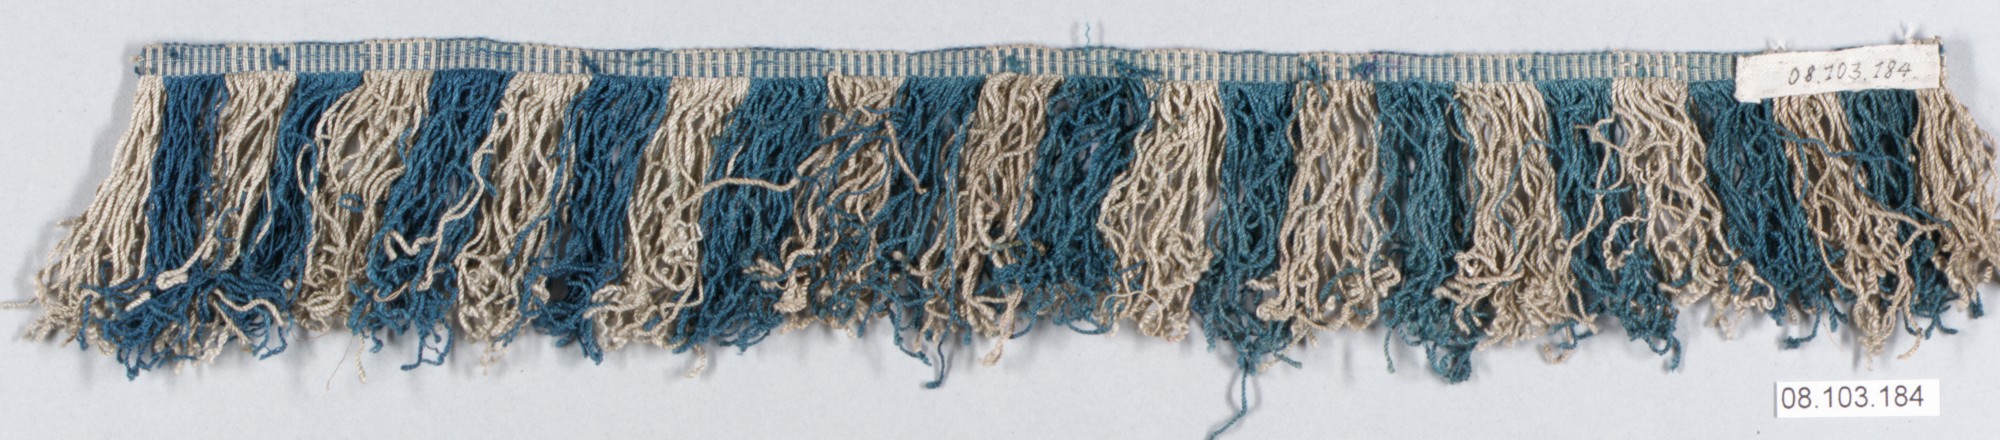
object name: fringe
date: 1801-1900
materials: silk